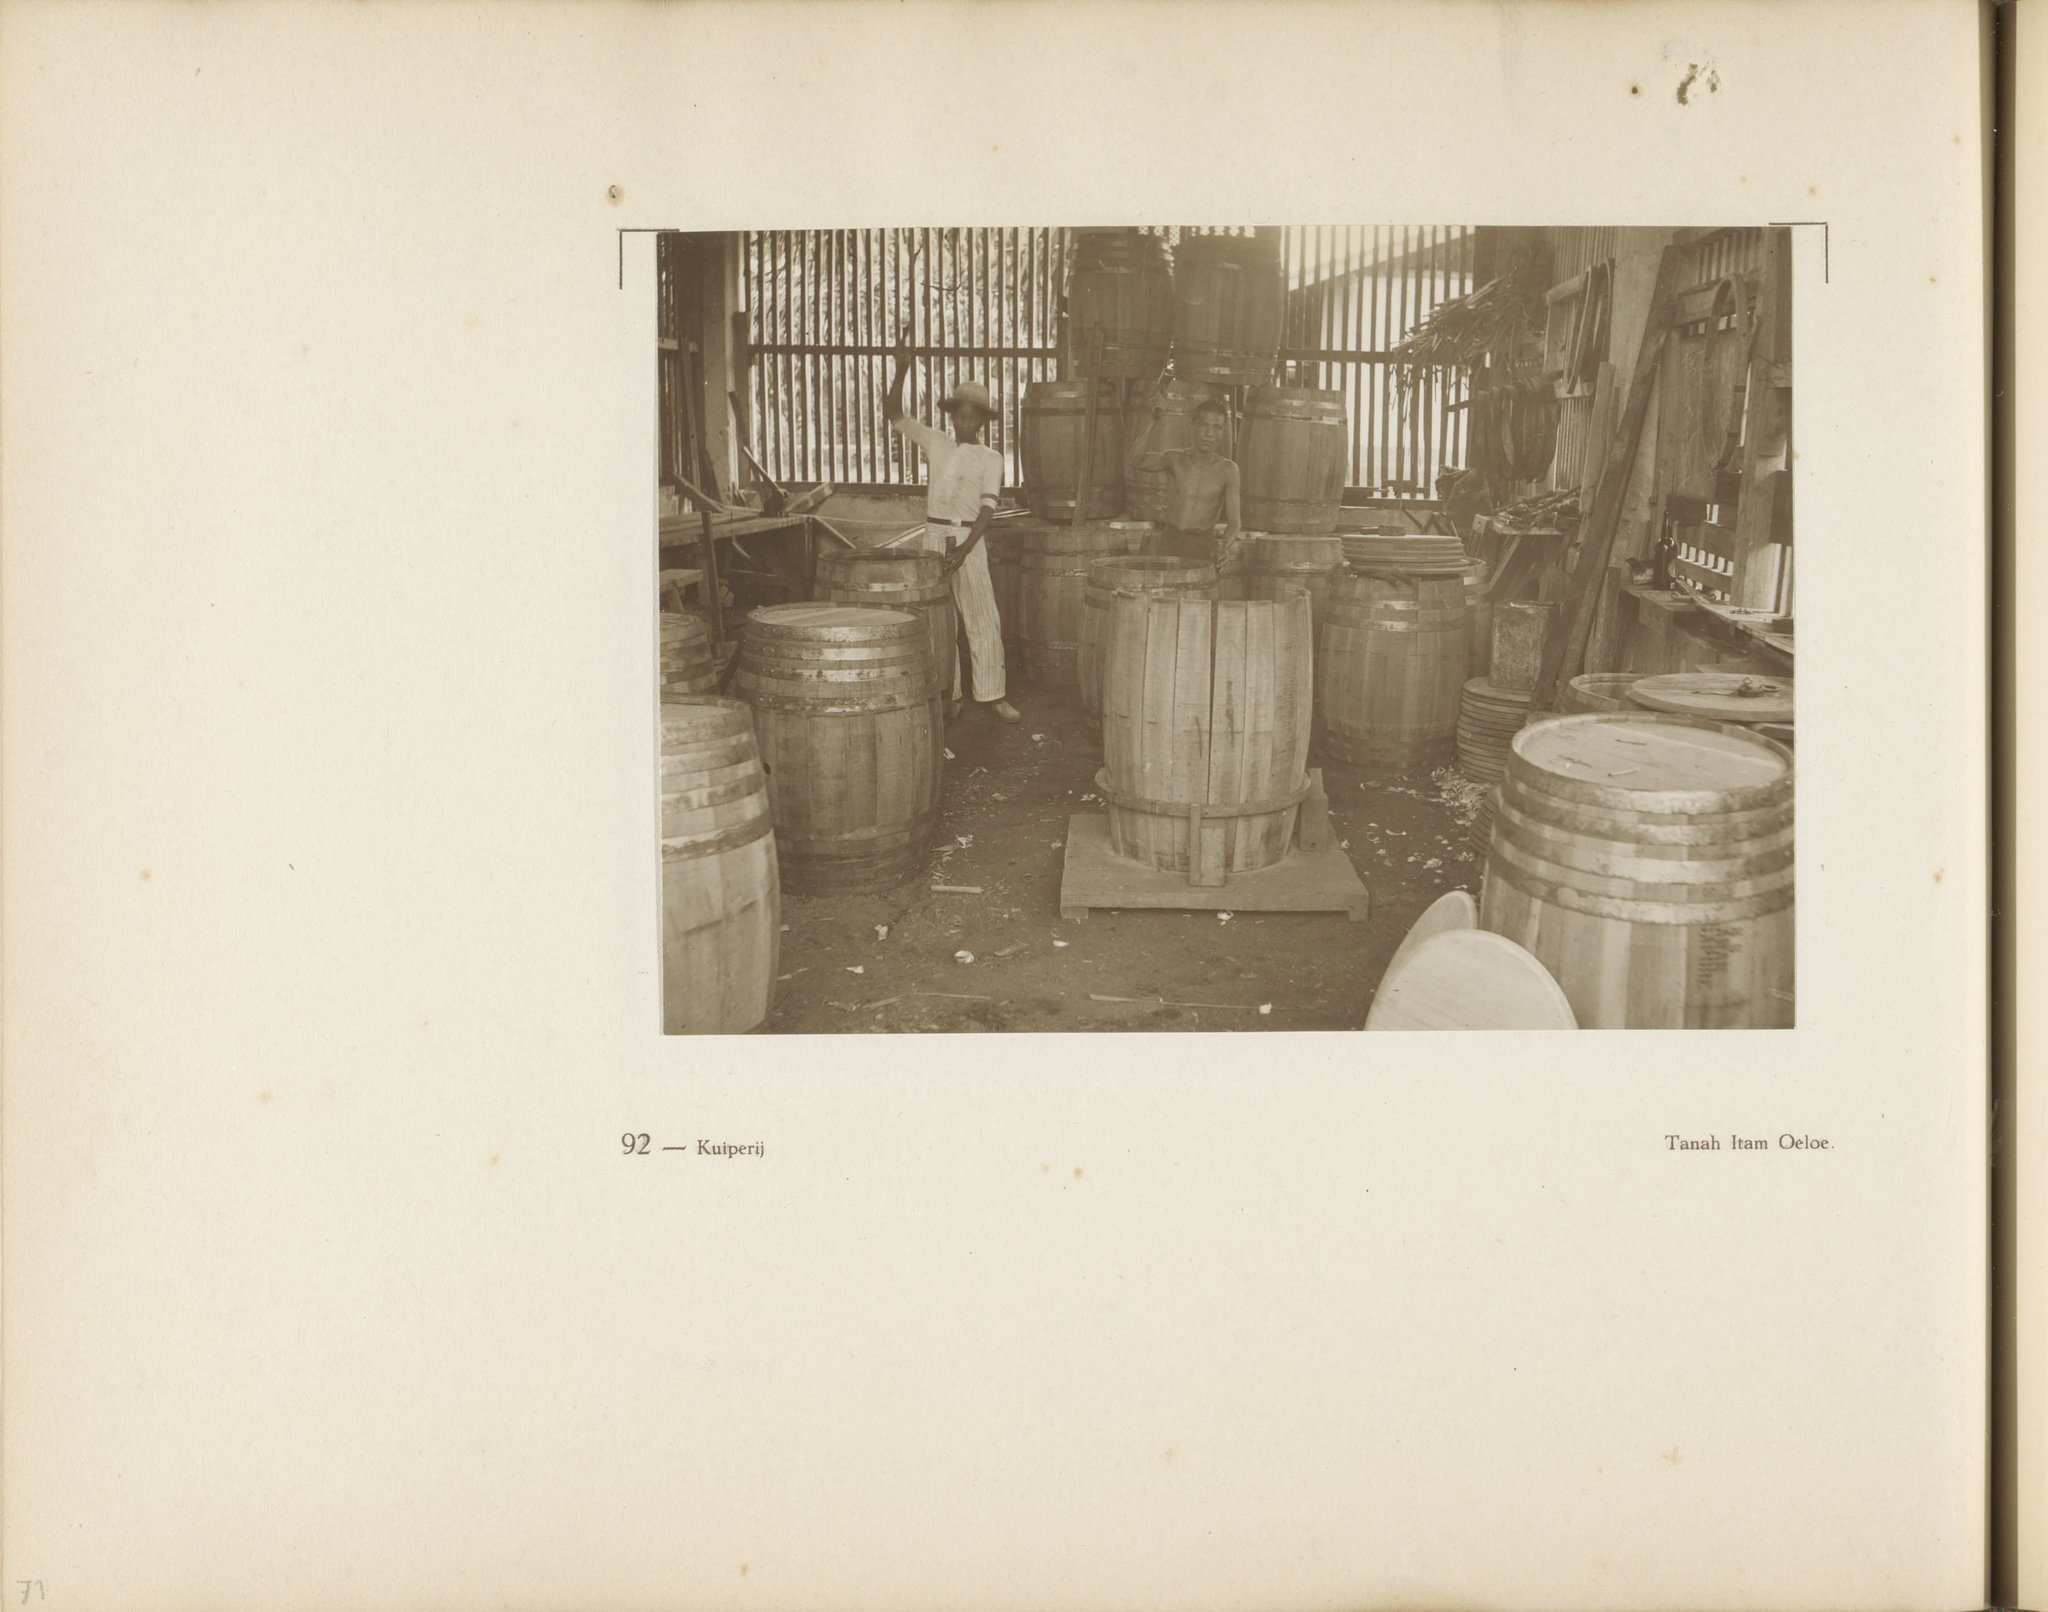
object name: album leaf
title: Pagina 92 van fotoboek van de Algemeene Vereeniging van Rubberplanters ter Oostkust van Sumatra (A.V.R.O.S.)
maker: j.w. meyster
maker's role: fotograaf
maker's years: 1887-1945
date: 1924-1925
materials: paper, photographic support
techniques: printing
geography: sumatra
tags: wooden container: barrel, cask, bucket, factory-building, factory-interior, machine shop, (non-fruit) products of plants or trees: rubber, trees: palm-tree, sumatra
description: Boekpagina met een foto van een kuiperij in een fabriek voor palmoliebereiding te Tanah Itam Oeloe. Onderdeel van een fotoboek van de Algemeene Vereeniging van Rubberplanters ter Oostkust van Sumatra (A.V.R.O.S.).